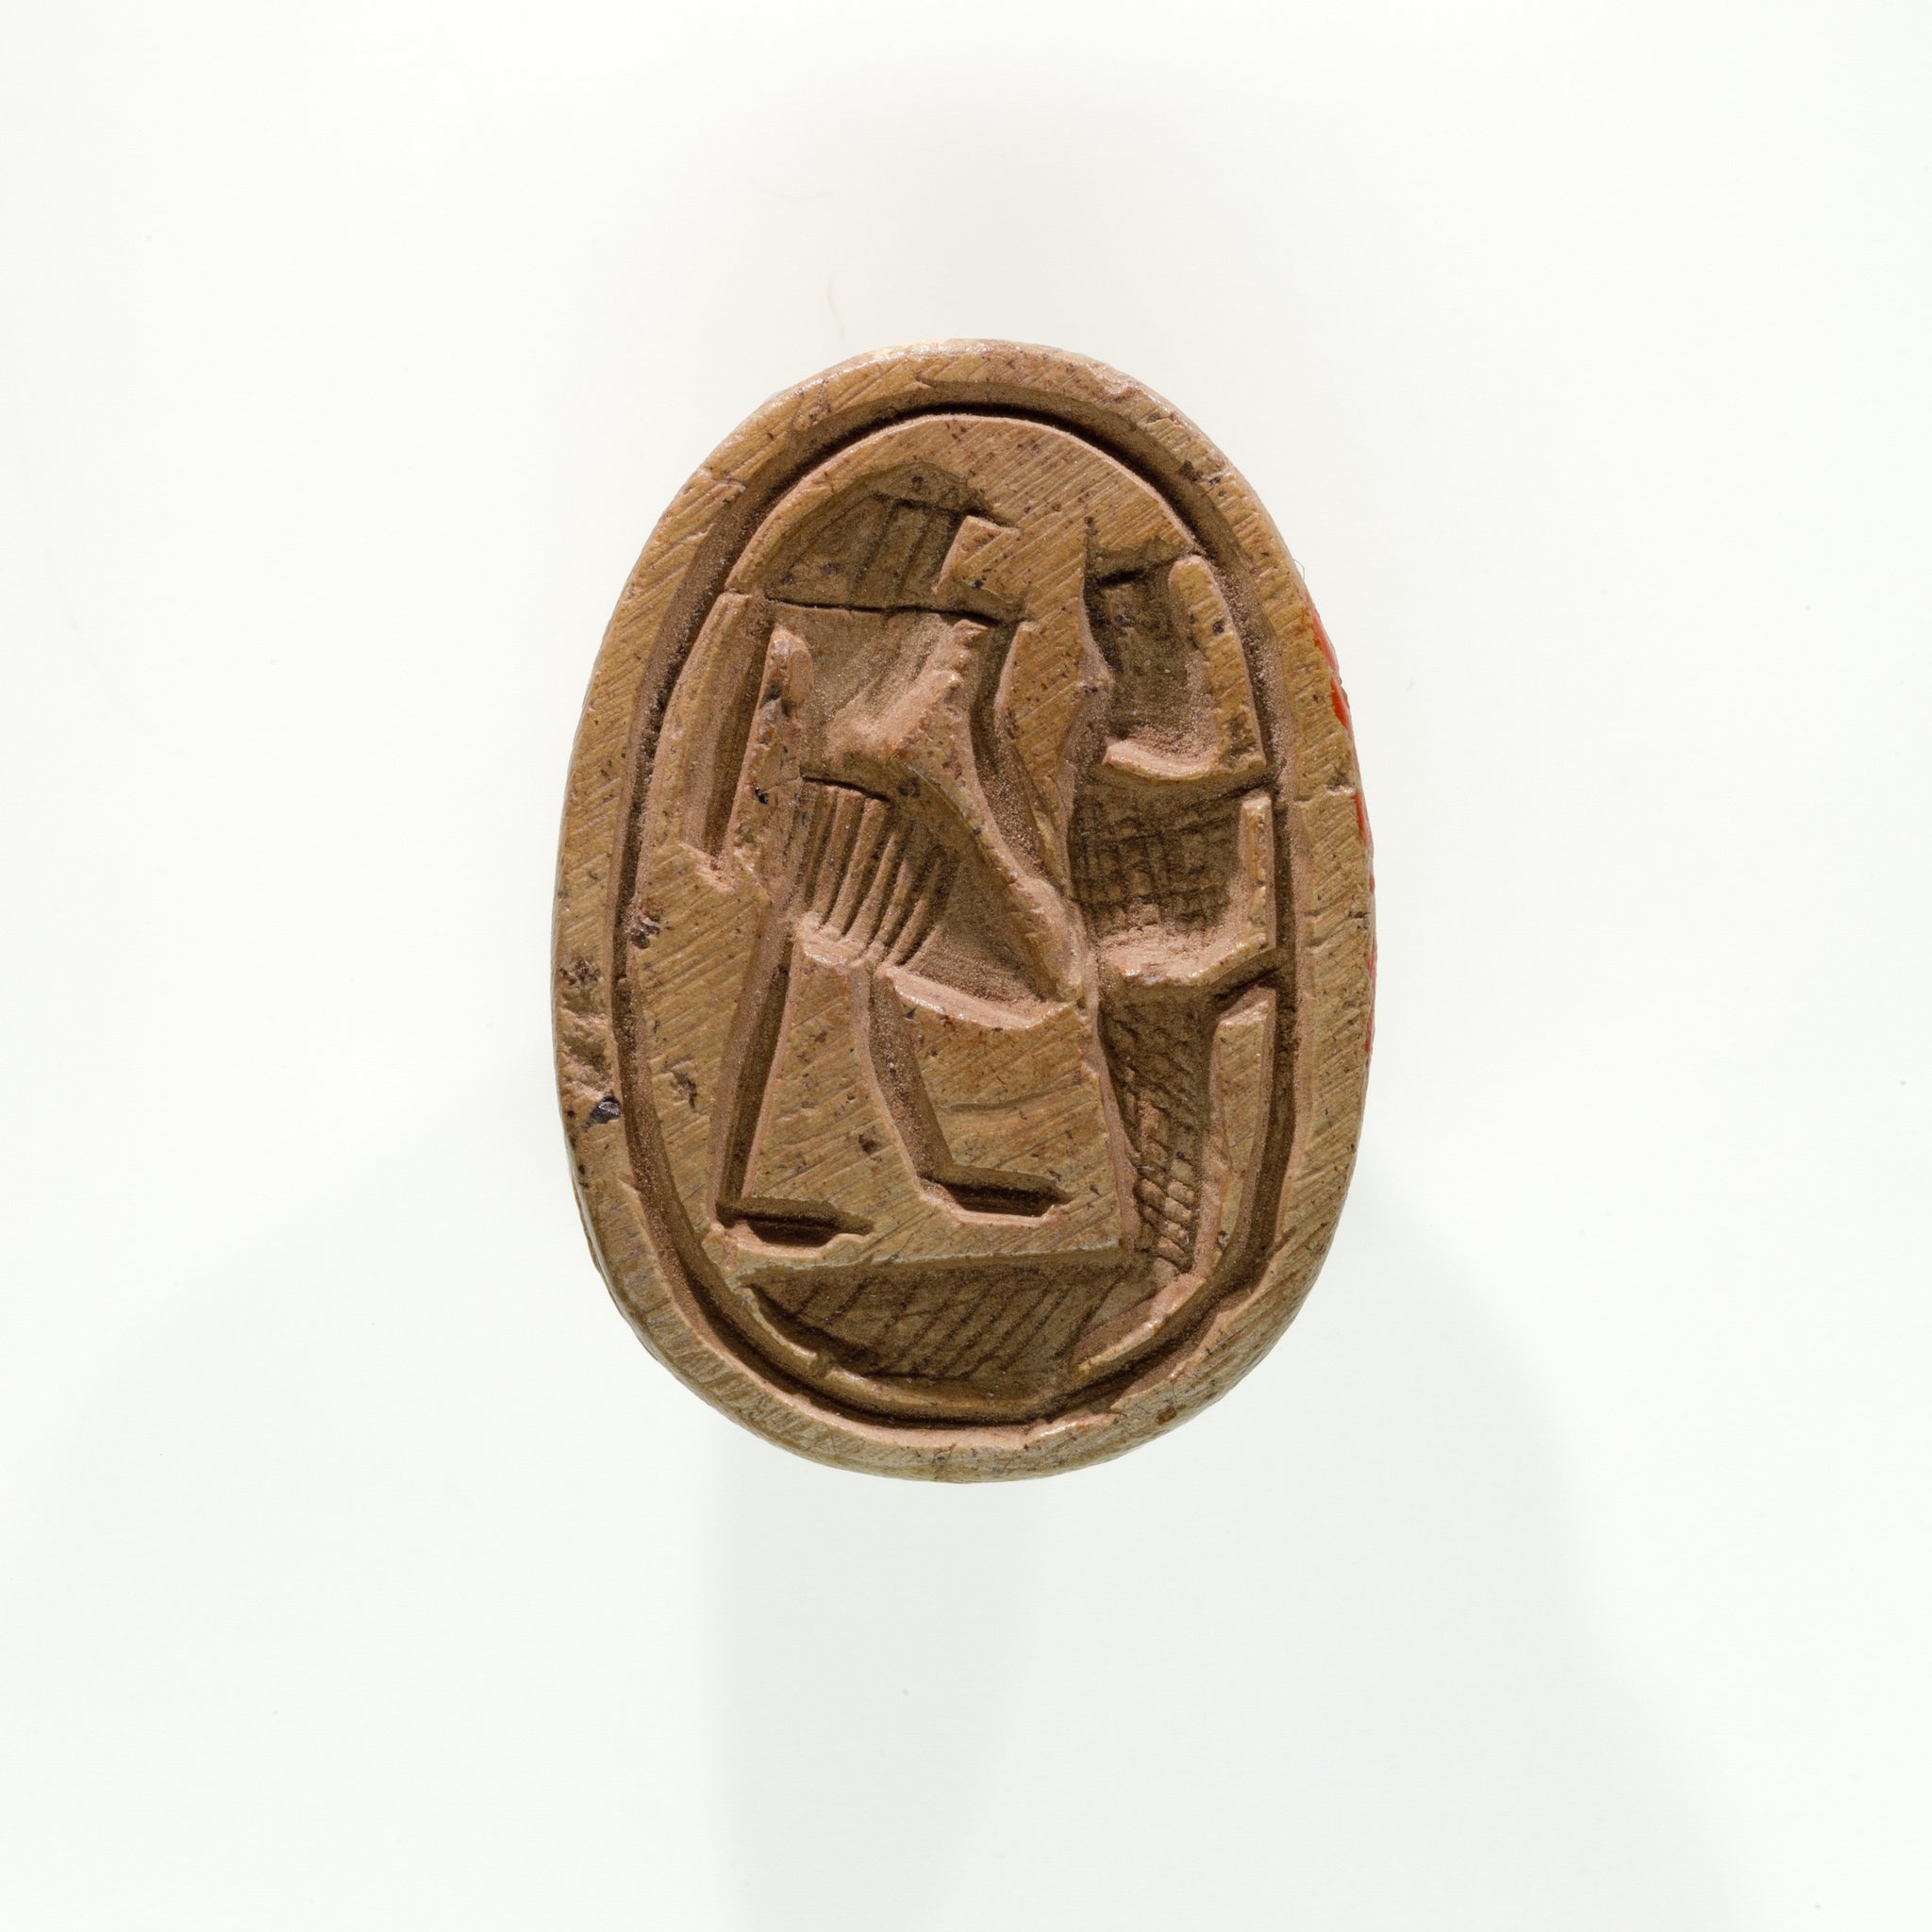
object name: scarab, ruiu, horus, crocodile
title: Scarab from Ruiu's Burial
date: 1504-1447 BCE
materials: stone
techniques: glazing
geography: egypt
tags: scarabs